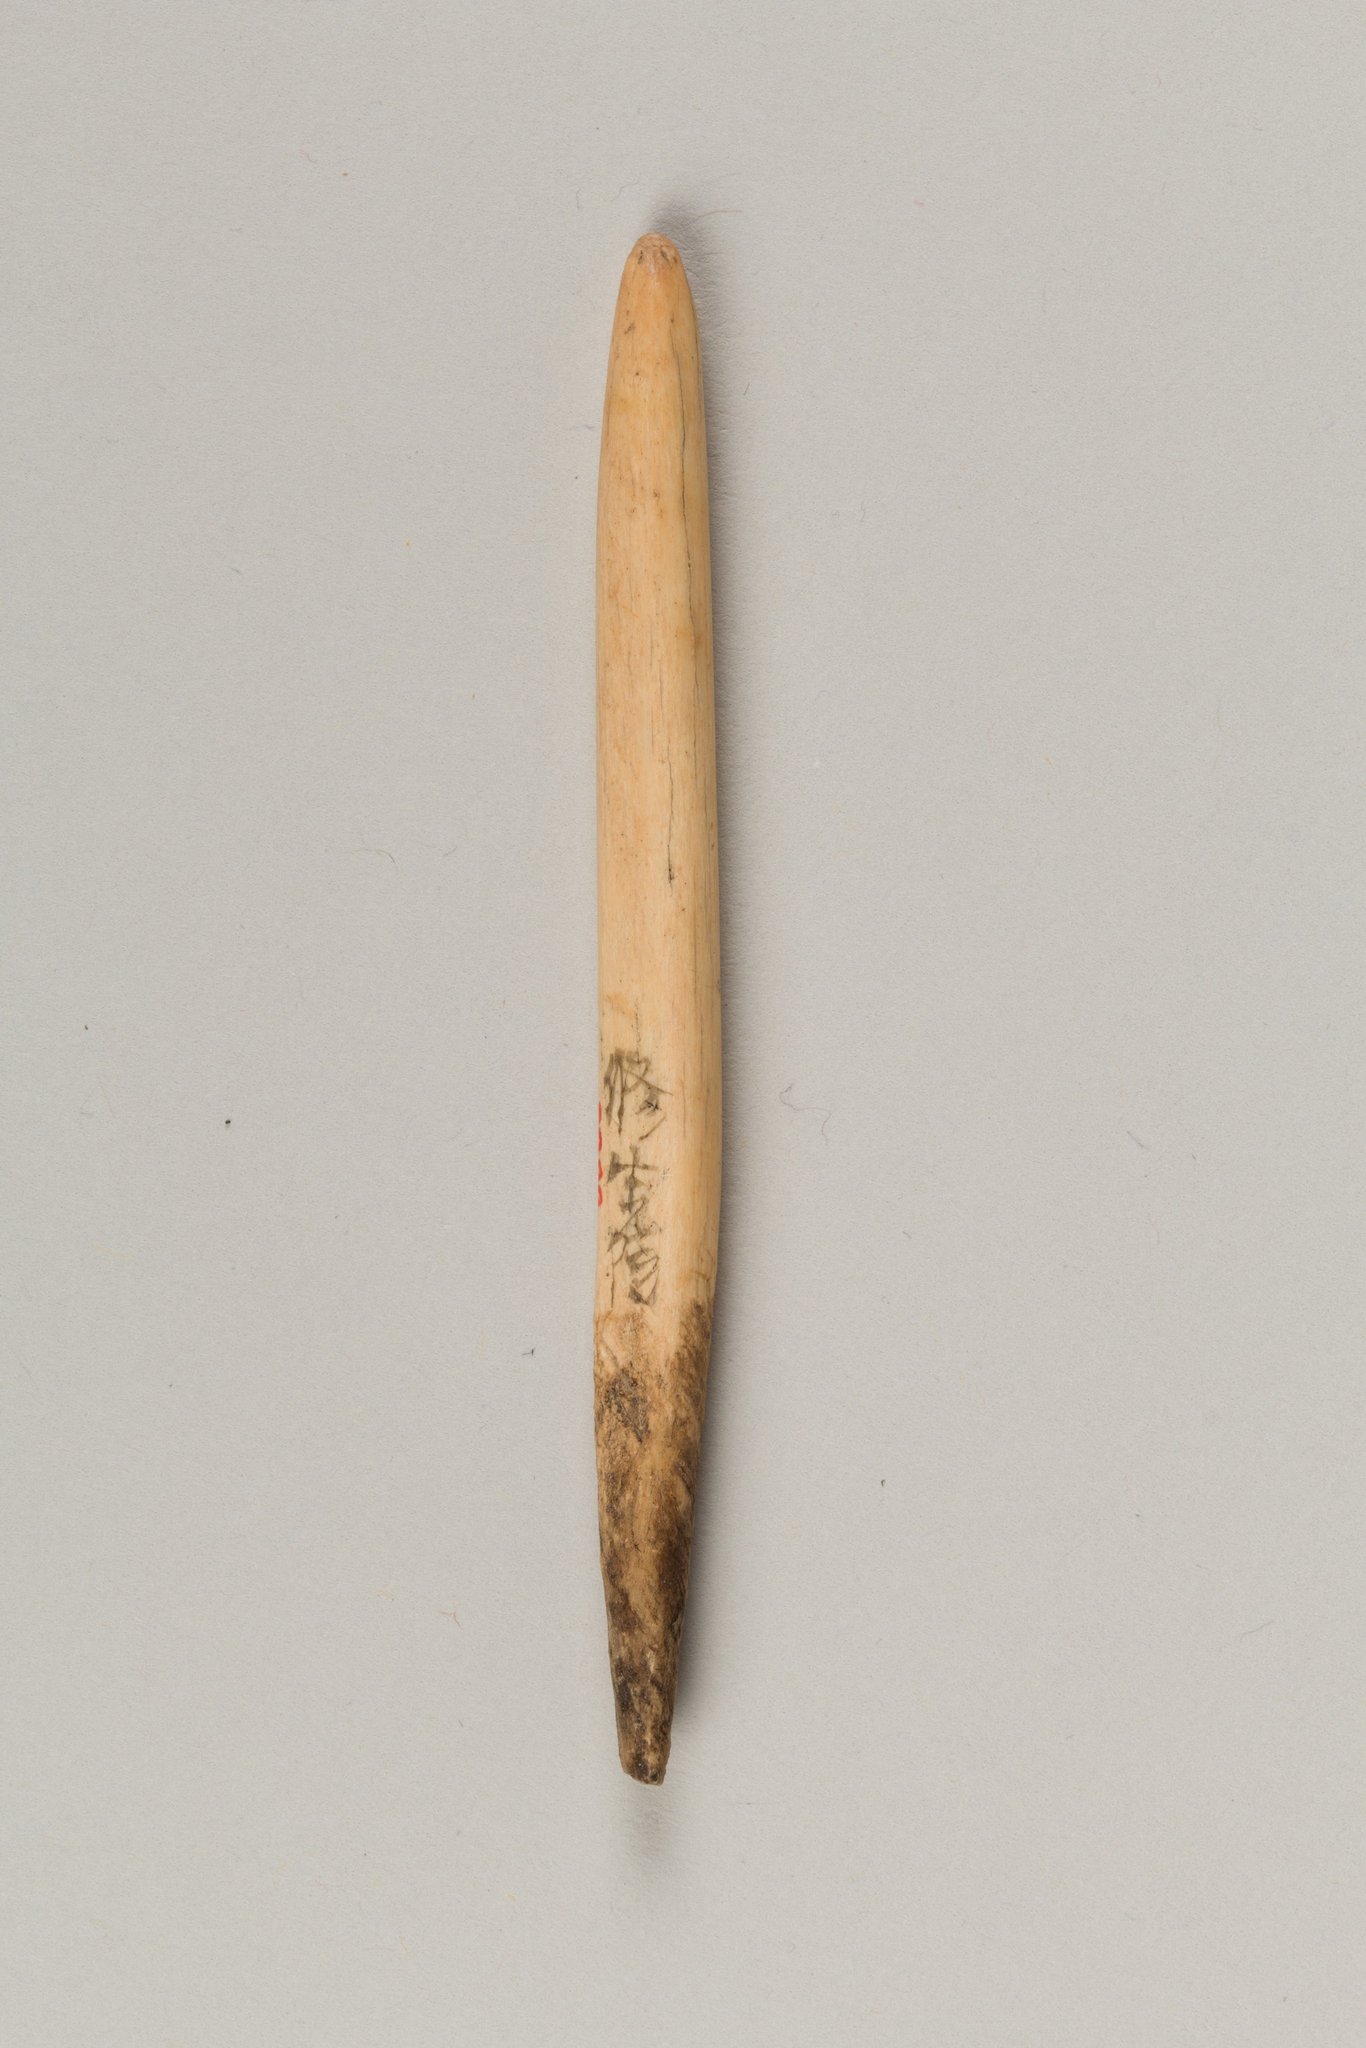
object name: harpoon head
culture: japanese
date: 1000-300 BCE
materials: bone